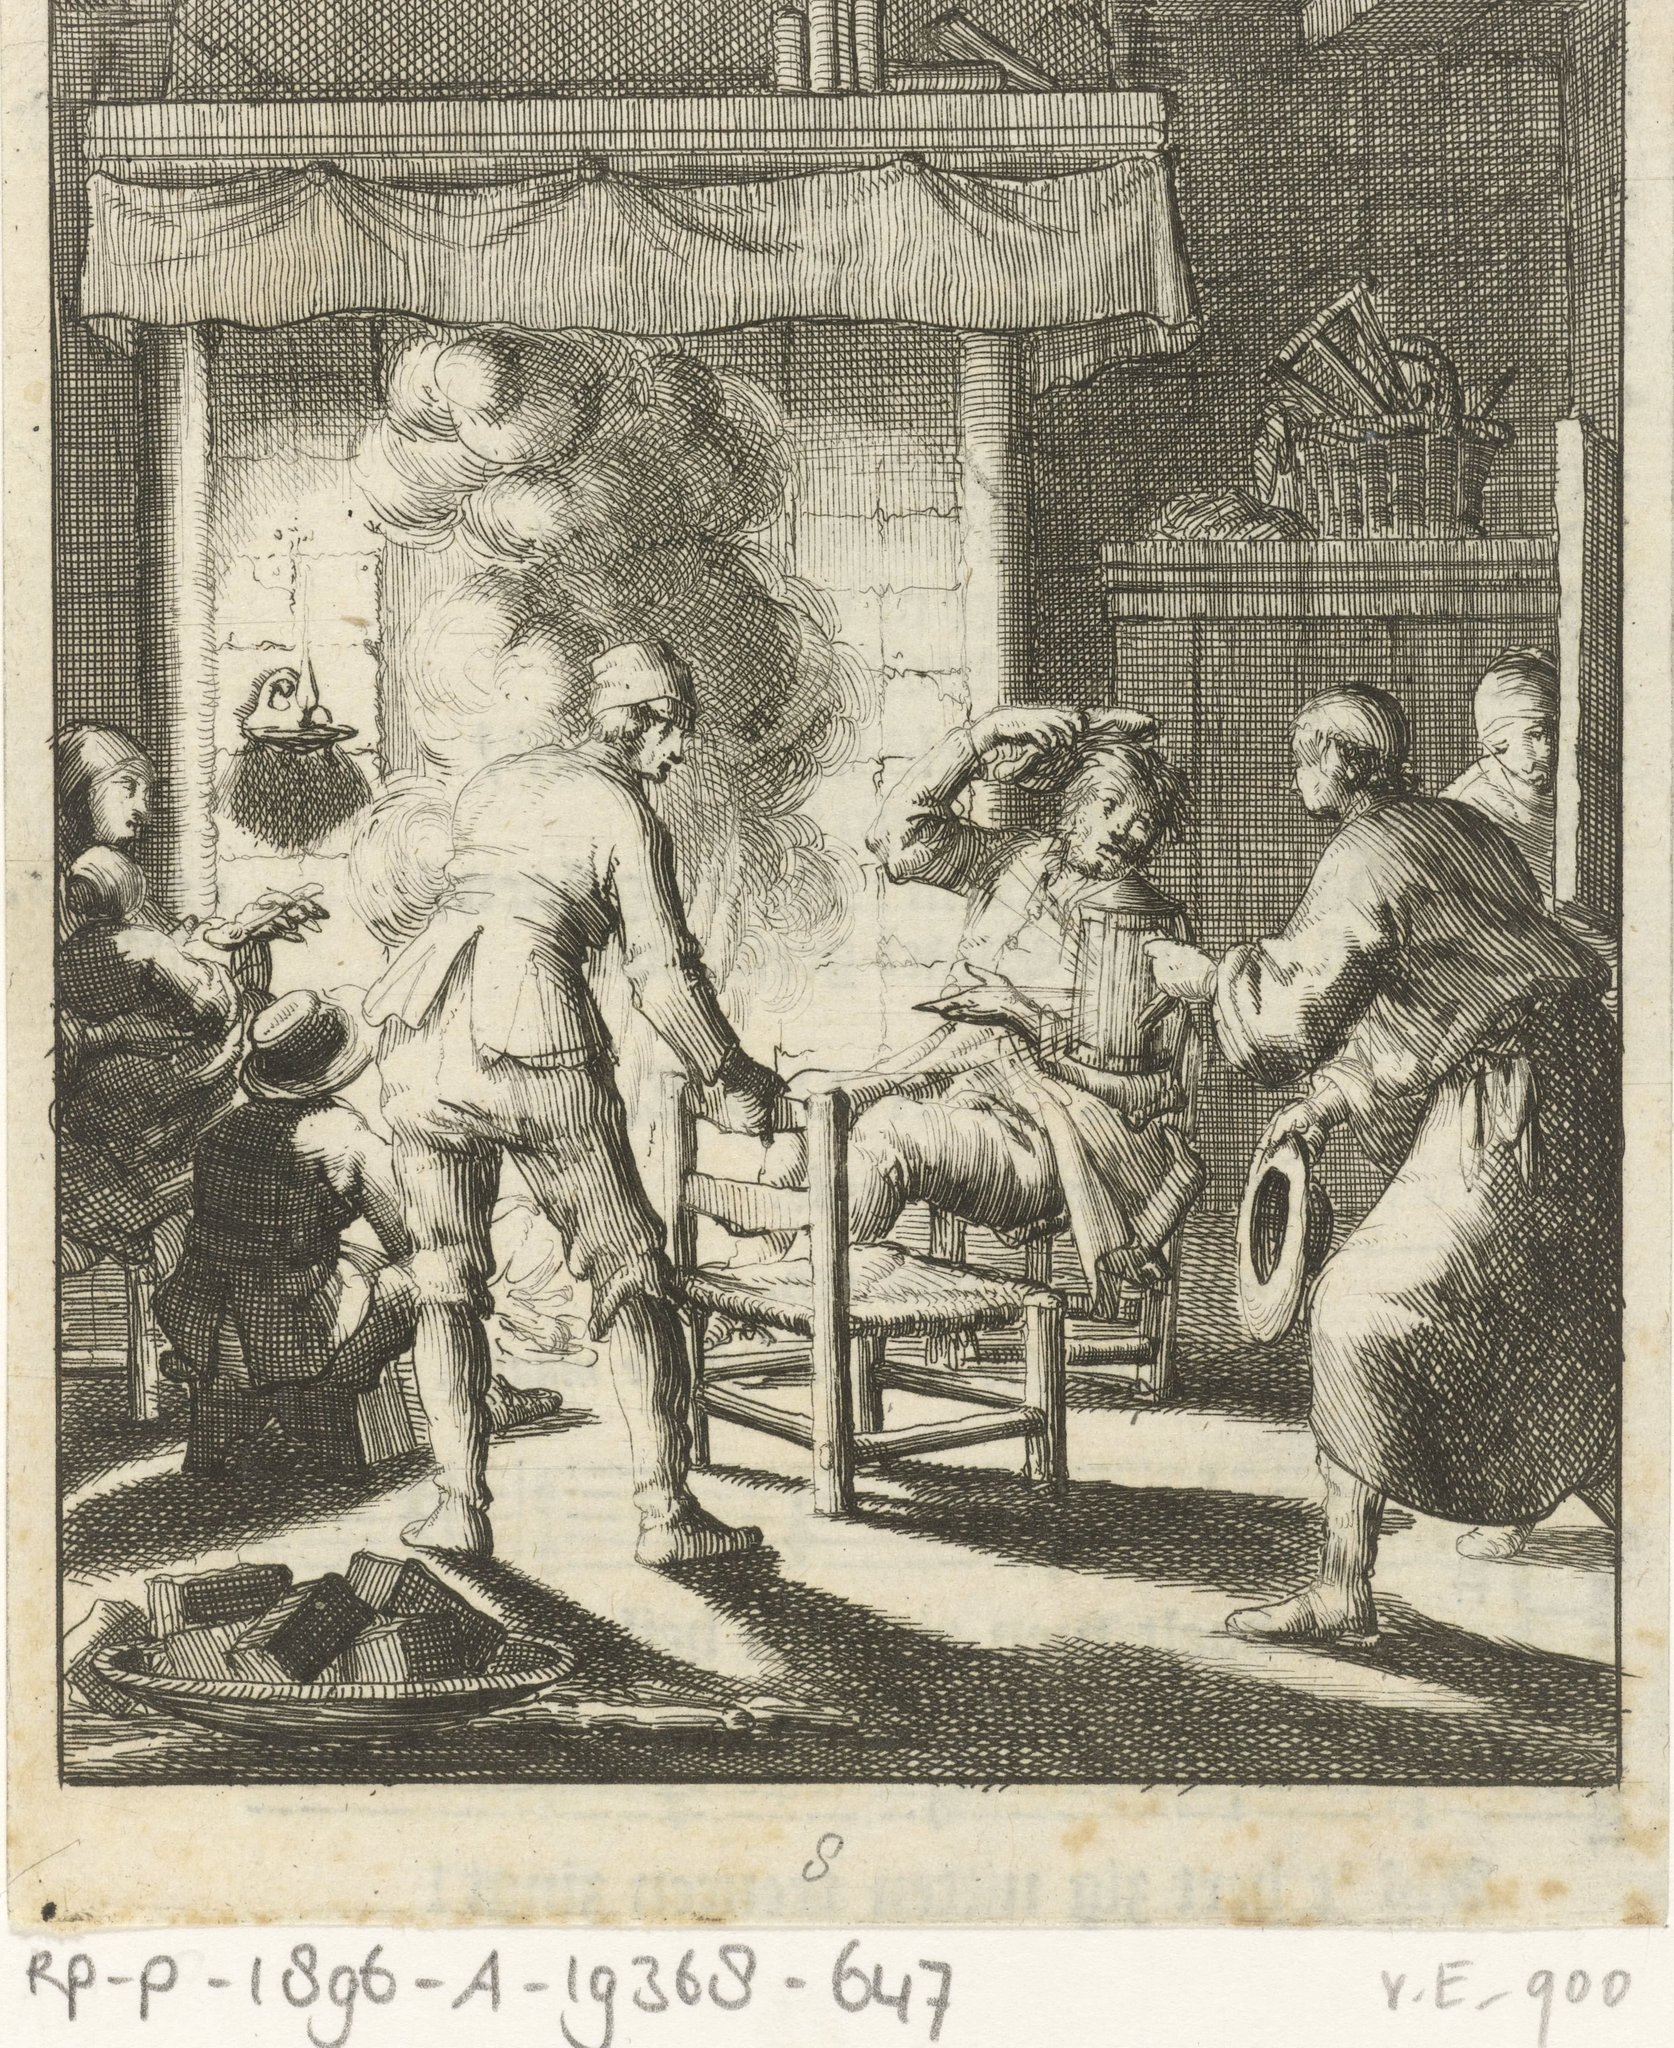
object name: book illustration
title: Vijf personen rondom het haardvuur verwelkomen de schrijver Willem Sluiter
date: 1687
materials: paper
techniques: etching, letterpress printing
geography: amsterdam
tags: saluting, open fire, fire-place, stove (in kitchen)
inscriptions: collector's mark: Lugt 2228, number: ‘8’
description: Illustratie uit: Sluiter, Willem. Buiten- eensaem huis- somer- en winter-leven. Amsterdam: Gerbrandt Schagen, 1687, p. 38.